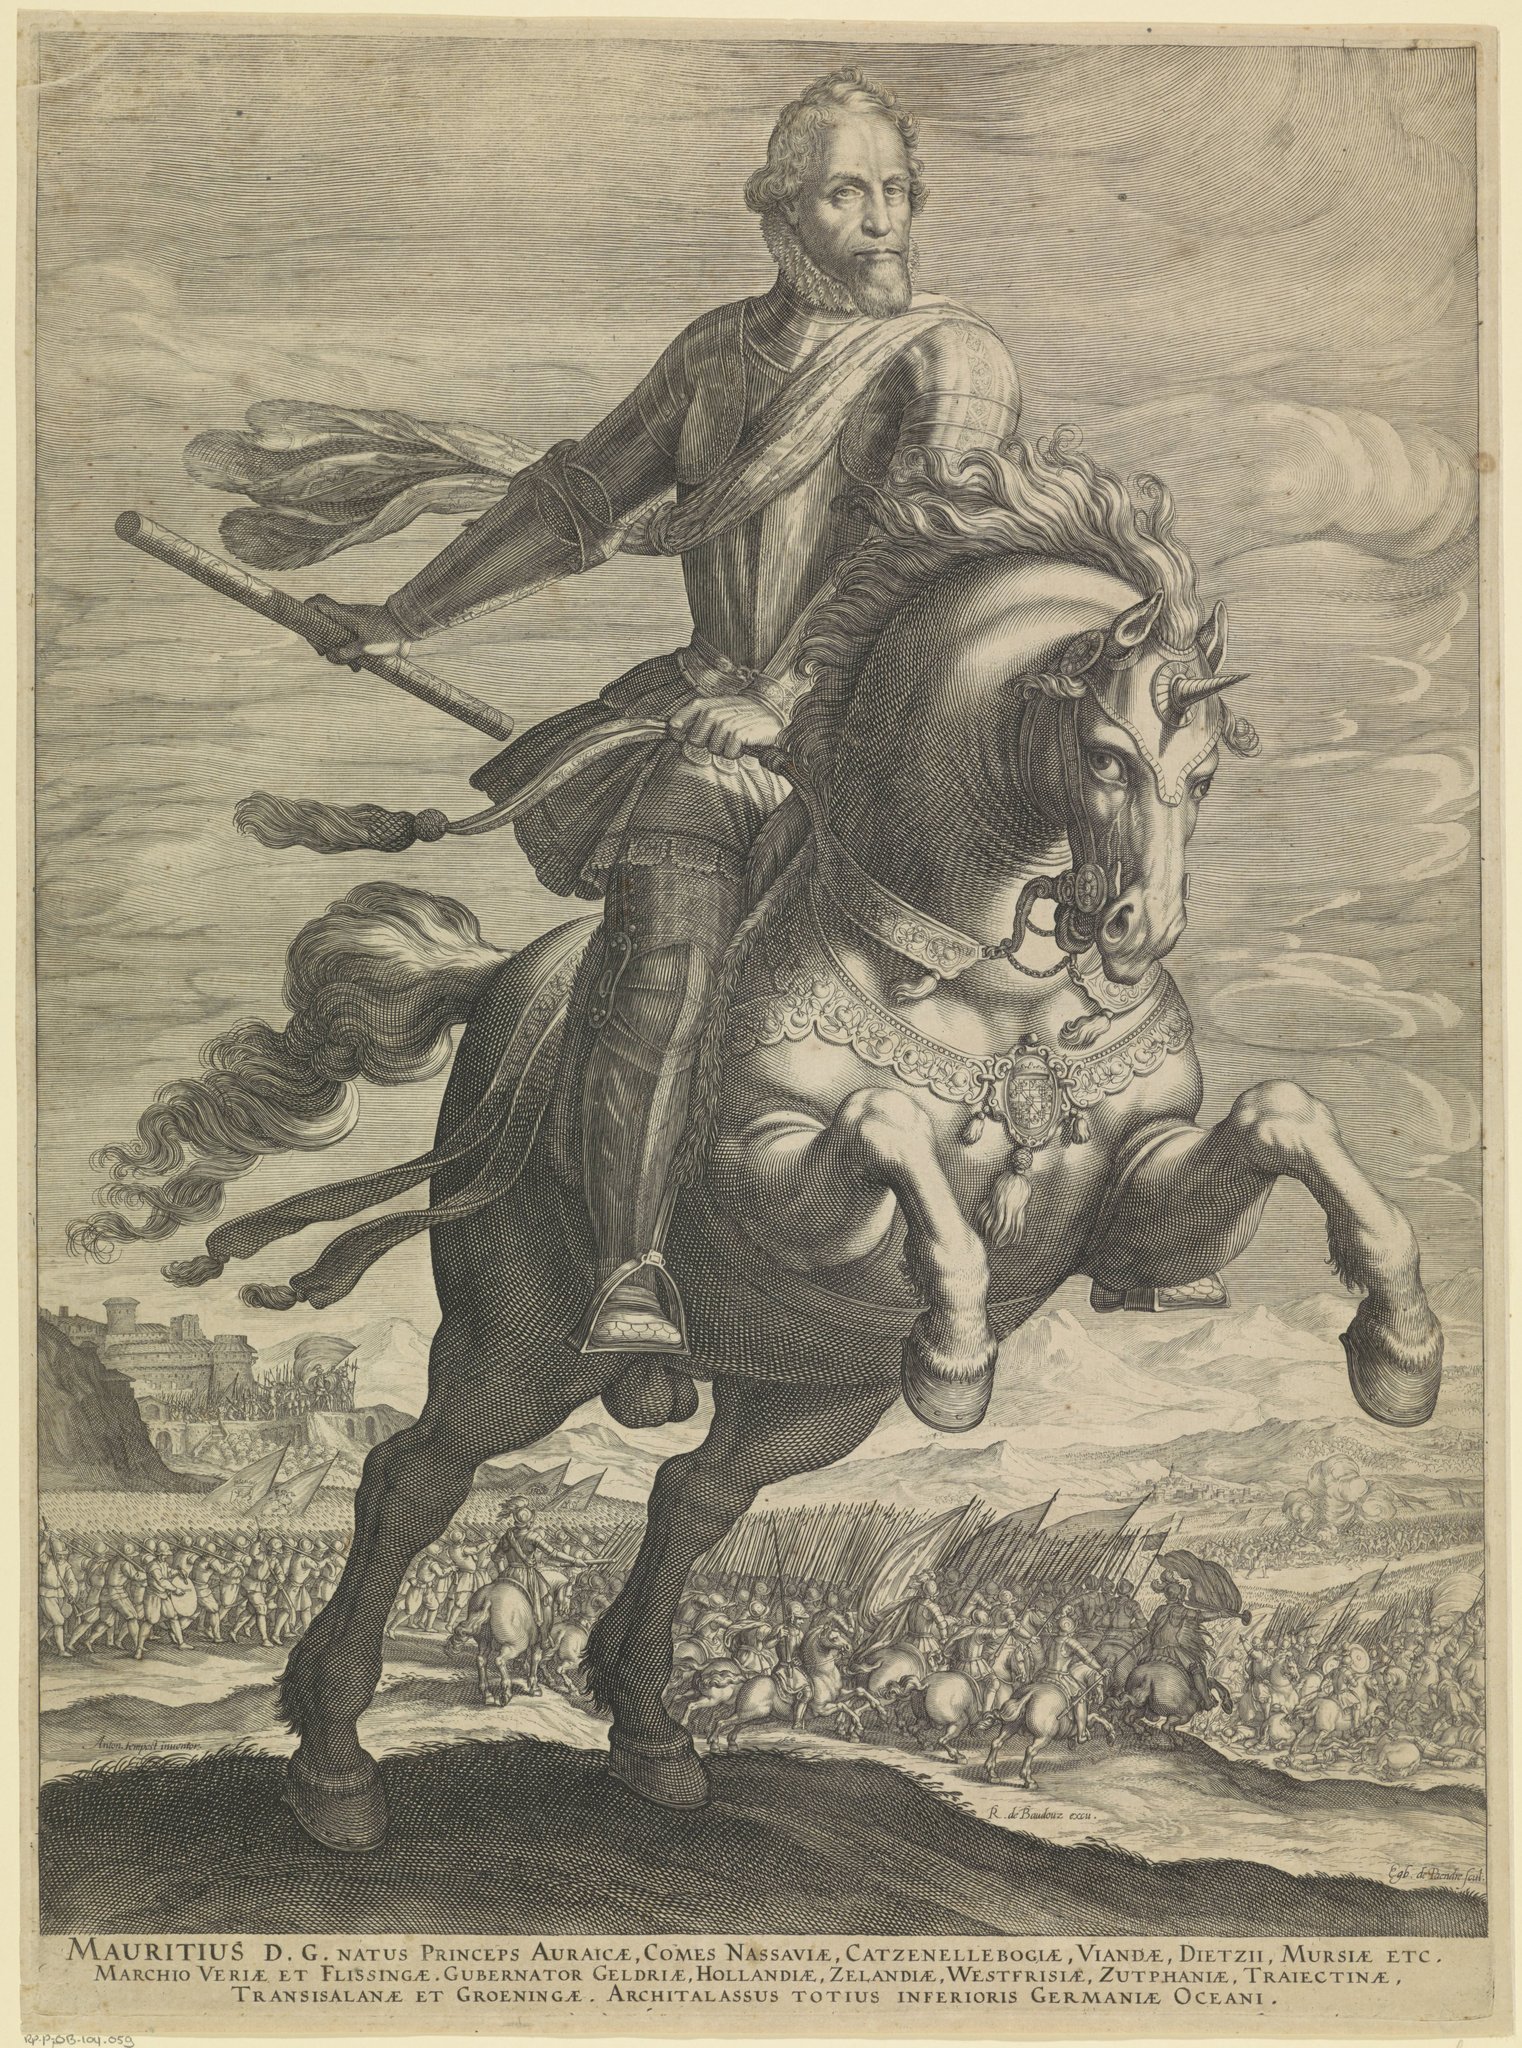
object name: print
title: Ruiterportret van Maurits, prins van Oranje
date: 1597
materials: paper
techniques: engraving, etching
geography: low countries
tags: maurice (prince of orange)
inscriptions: collector's mark: Lugt 2228, collector's mark: Lugt 963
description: De hier vermelde titel verwijst naar de hoogst verkregen titel van de geportretteerde, niet per se naar de titel die de geportretteerde op deze voorstelling draagt.